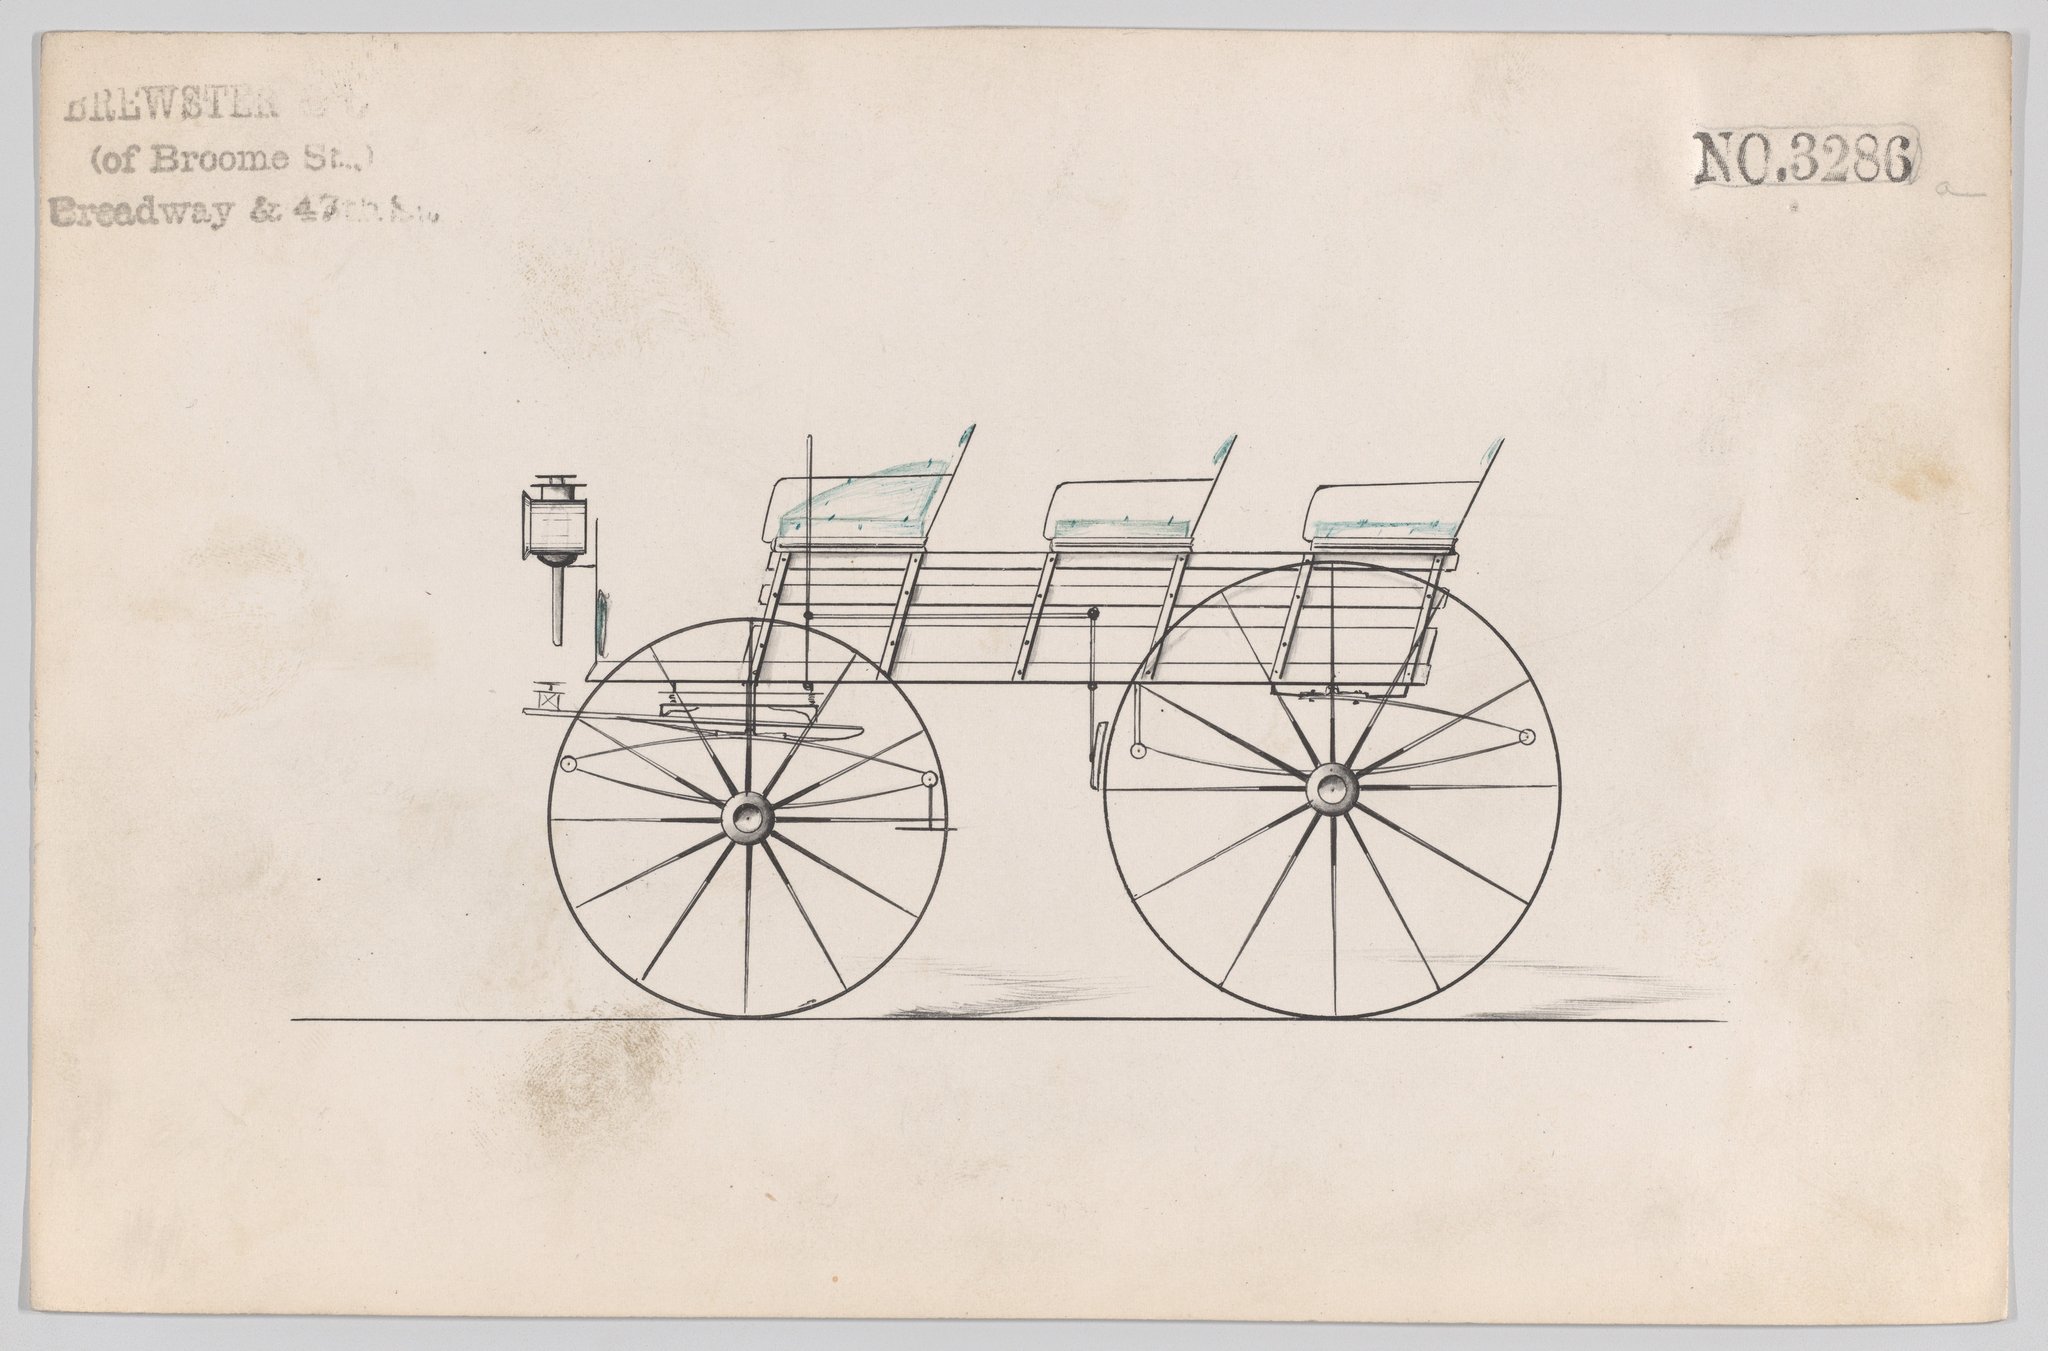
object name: drawing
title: Slat Side Phaeton #3286a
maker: brewster & co.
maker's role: manufacturer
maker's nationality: american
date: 1876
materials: ink, watercolor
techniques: pen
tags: carriages